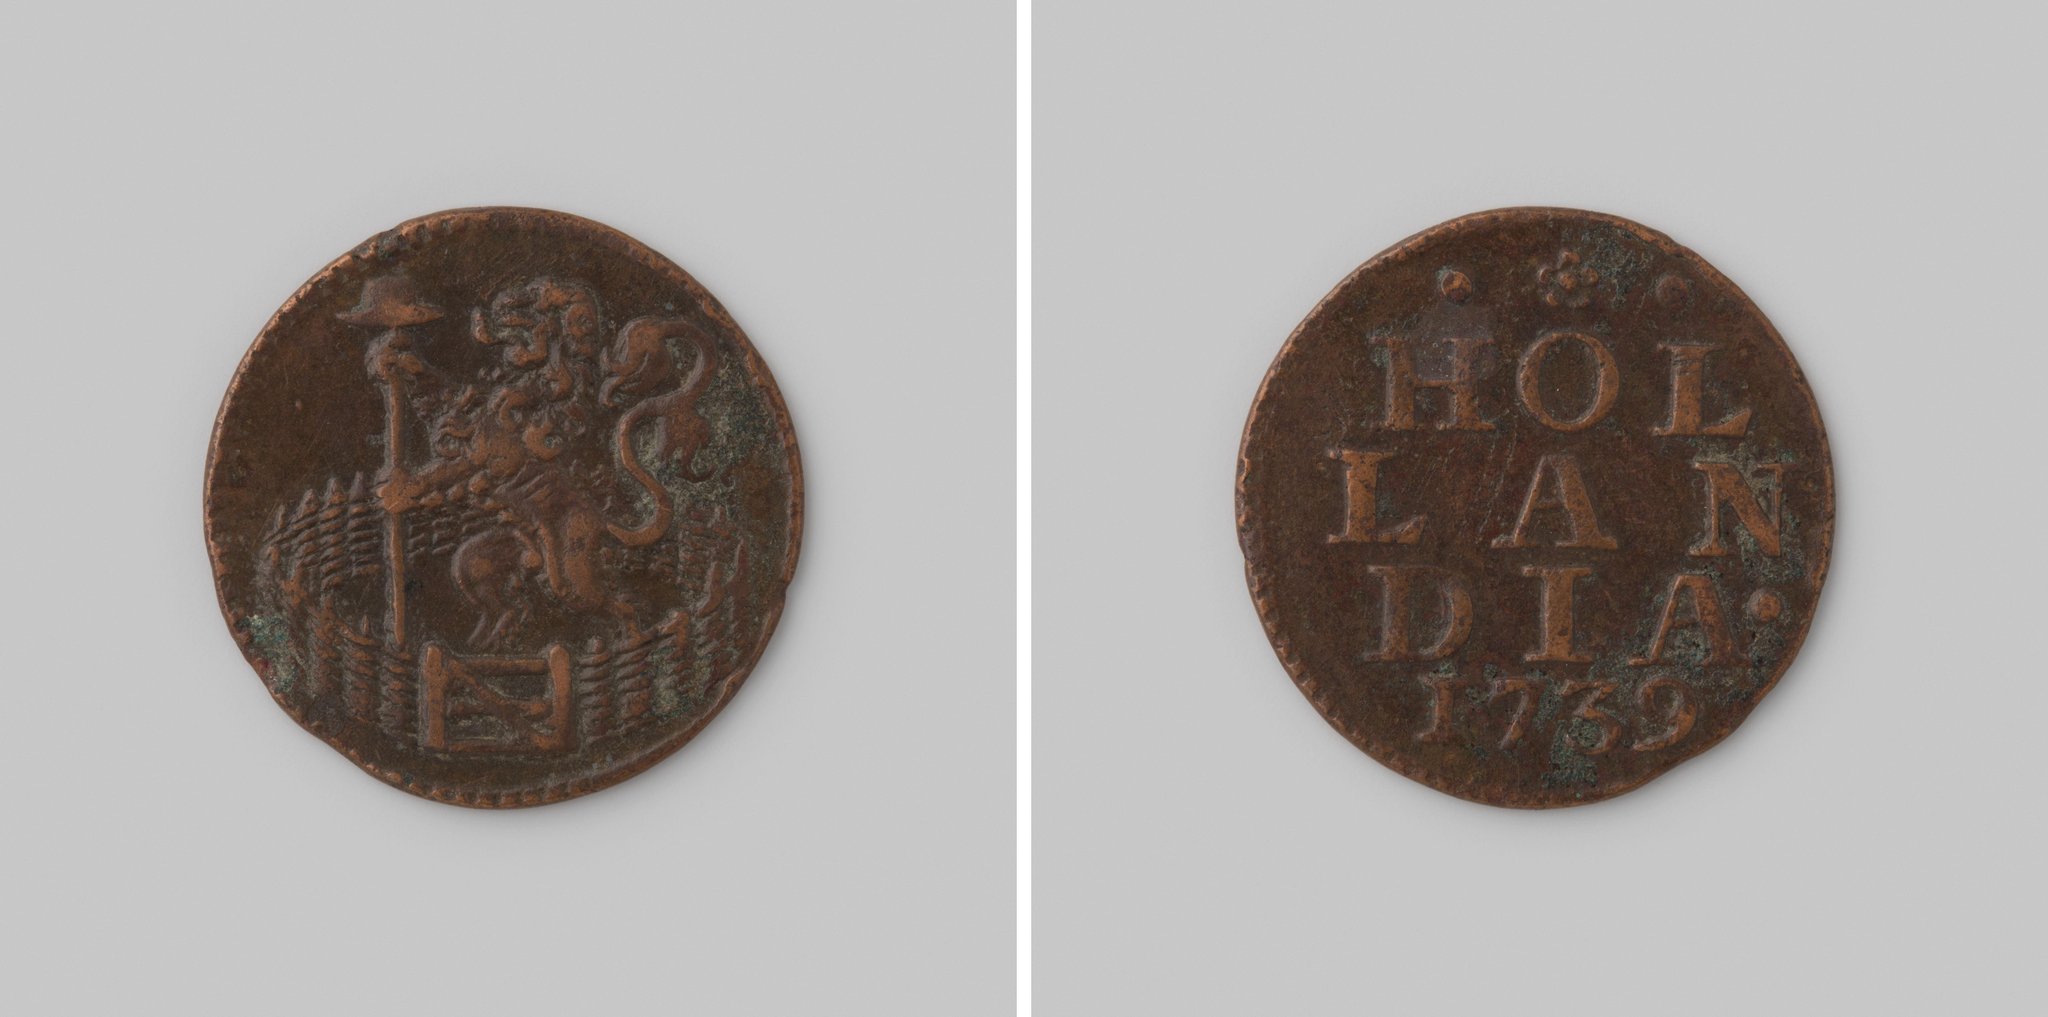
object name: coin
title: Holland, duit, 1739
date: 1739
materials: copper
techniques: striking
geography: dordrecht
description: Koperen munt. Voorzijde: binnen omheining staande leeuw met vrijheidshoed op speer. Keerzijde: opschrift: provincienaam in drie regels, daaronder jaartal.